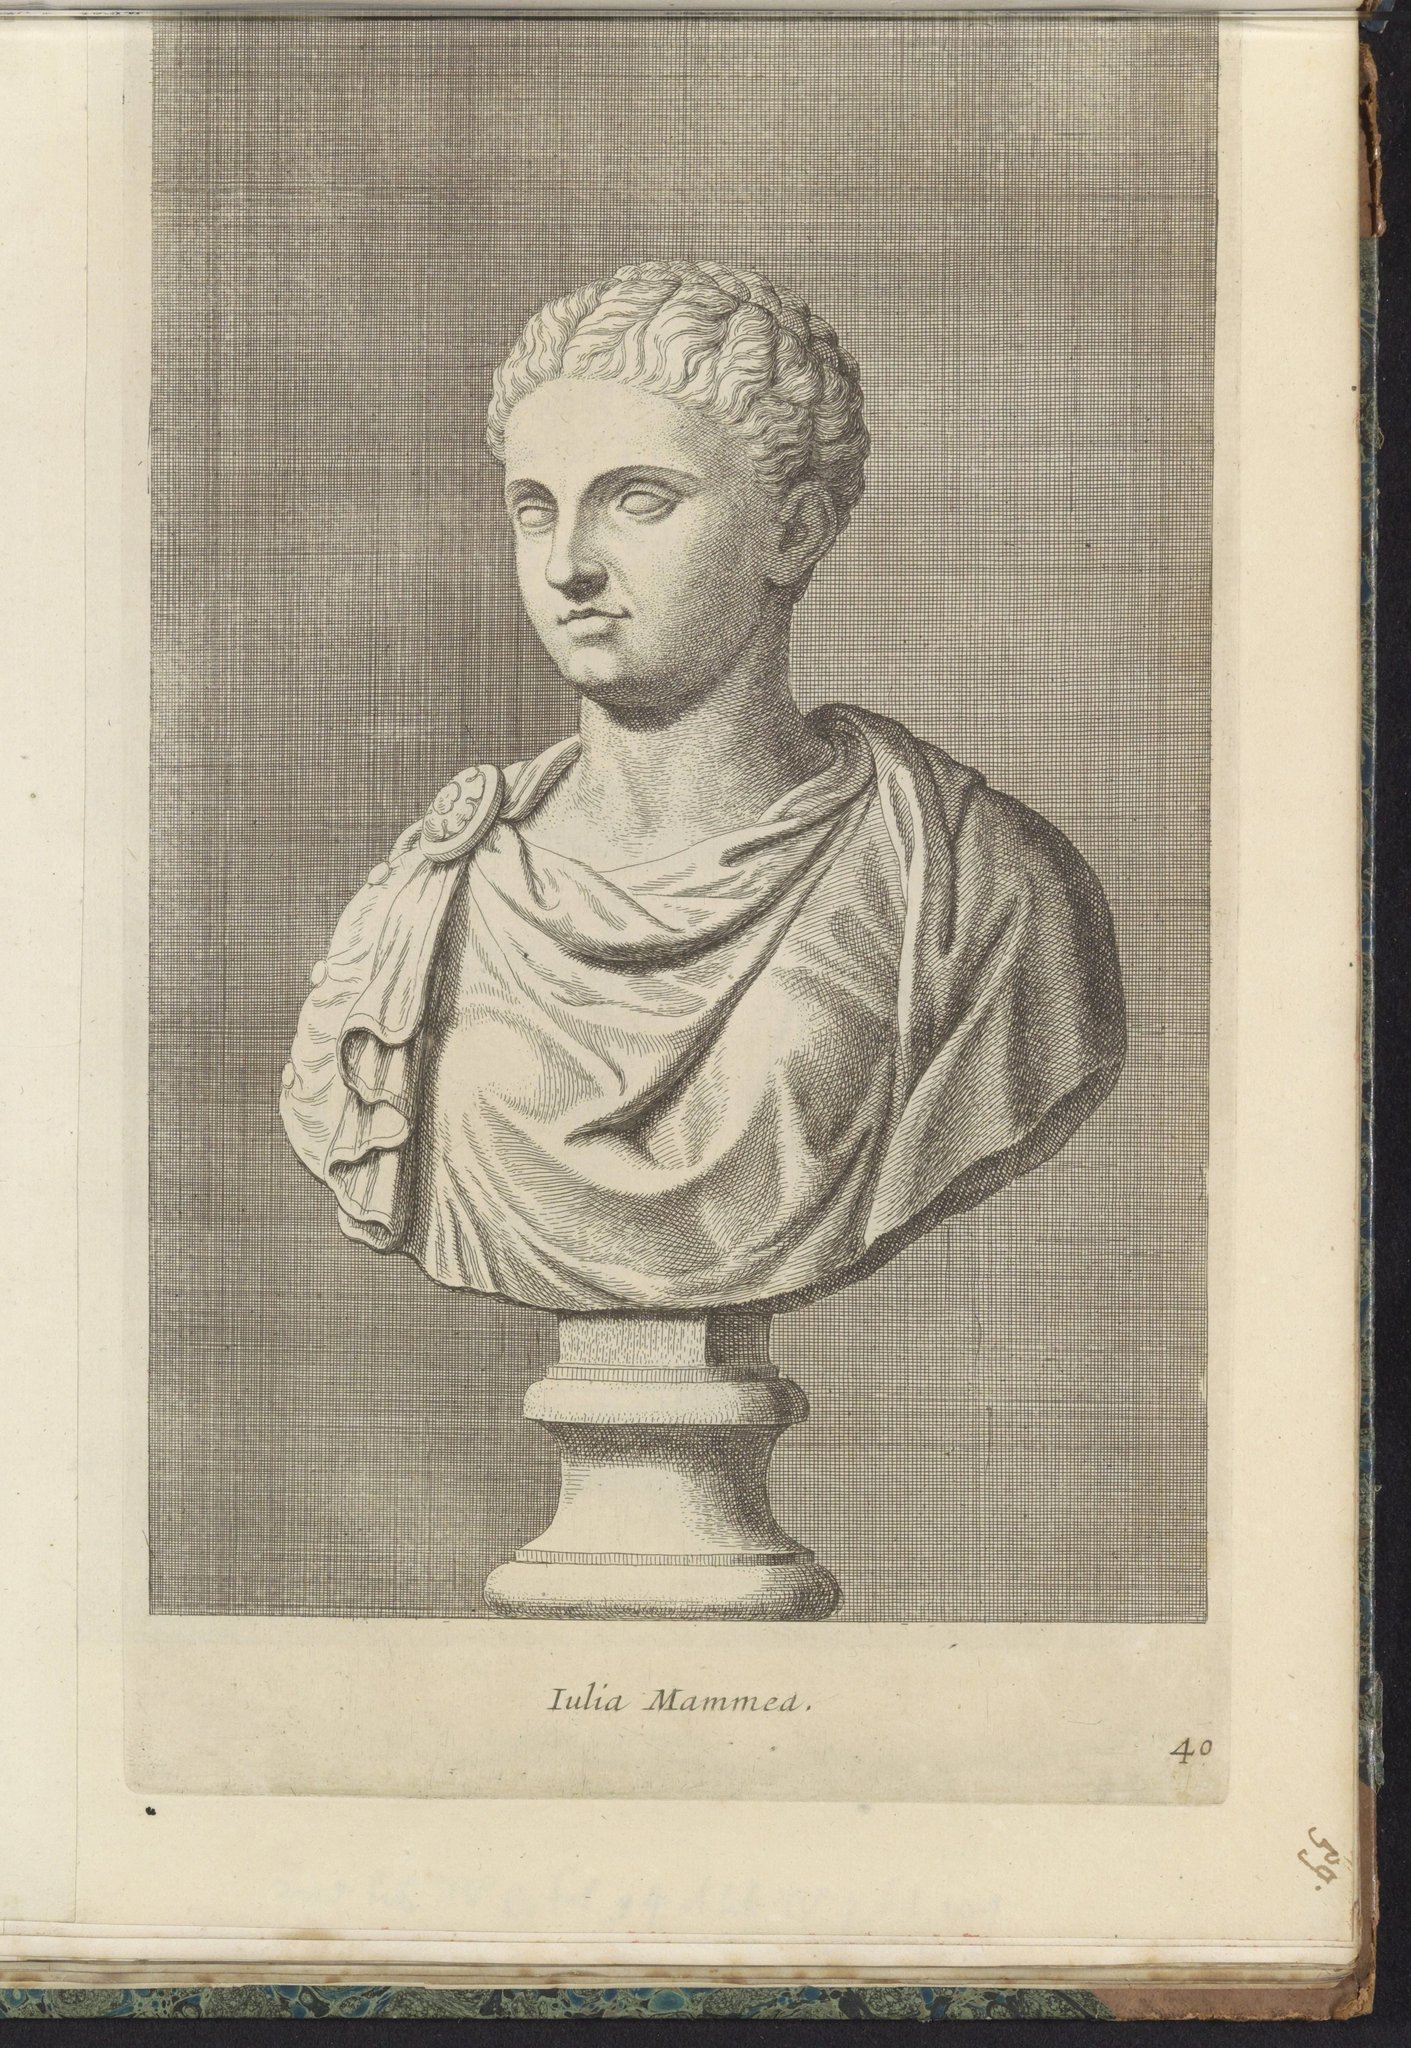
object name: album leaf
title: Julia Mammea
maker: hubert quellinus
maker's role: print maker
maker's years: 1619-1687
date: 1646-1670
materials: paper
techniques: engraving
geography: antwerp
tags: piece of sculpture, reproduction of a piece of sculpture, female persons from classical history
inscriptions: number: ‘59’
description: Klassieke buste van een vrouw. De prent maakt deel uit van een album met een serie prenten naar de sculpturen in de verzameling van Gerard Reynst.